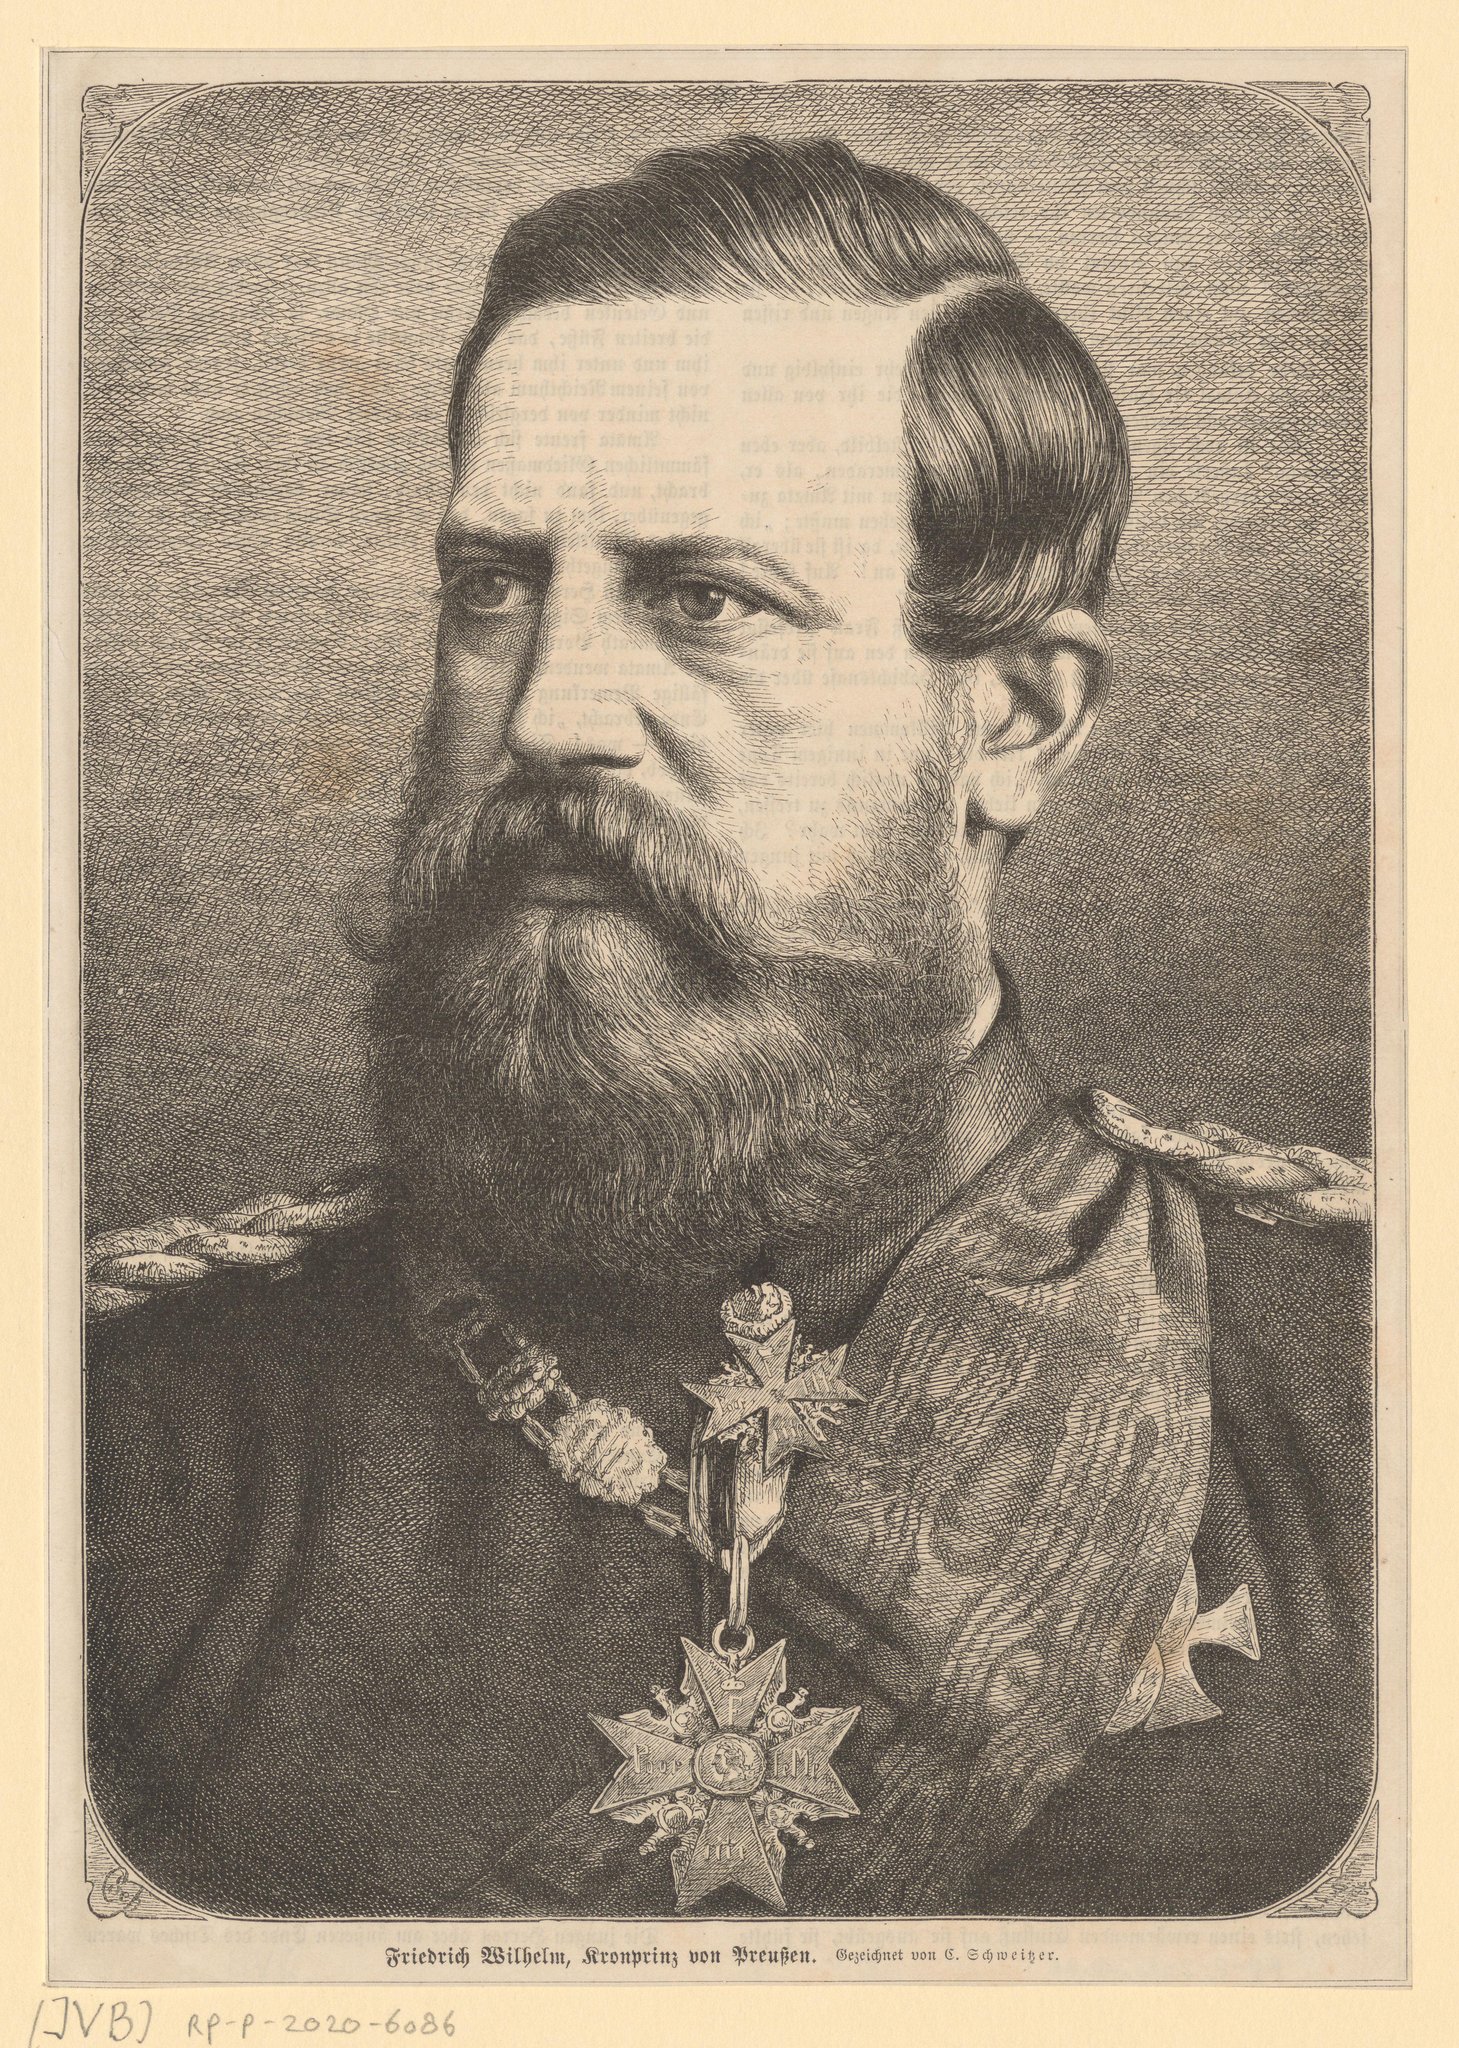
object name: print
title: Portret van Frederik III als kroonprins van Pruisen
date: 1870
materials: paper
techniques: letterpress printing, engraving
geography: leipzig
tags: historical persons, crown prince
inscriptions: collector's mark: ‘JVB’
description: Prent uit: Daheim: ein Deutsches Familienblatt mit Illustrationen 7 (1870), nr. 2, 8 oktober 1870.